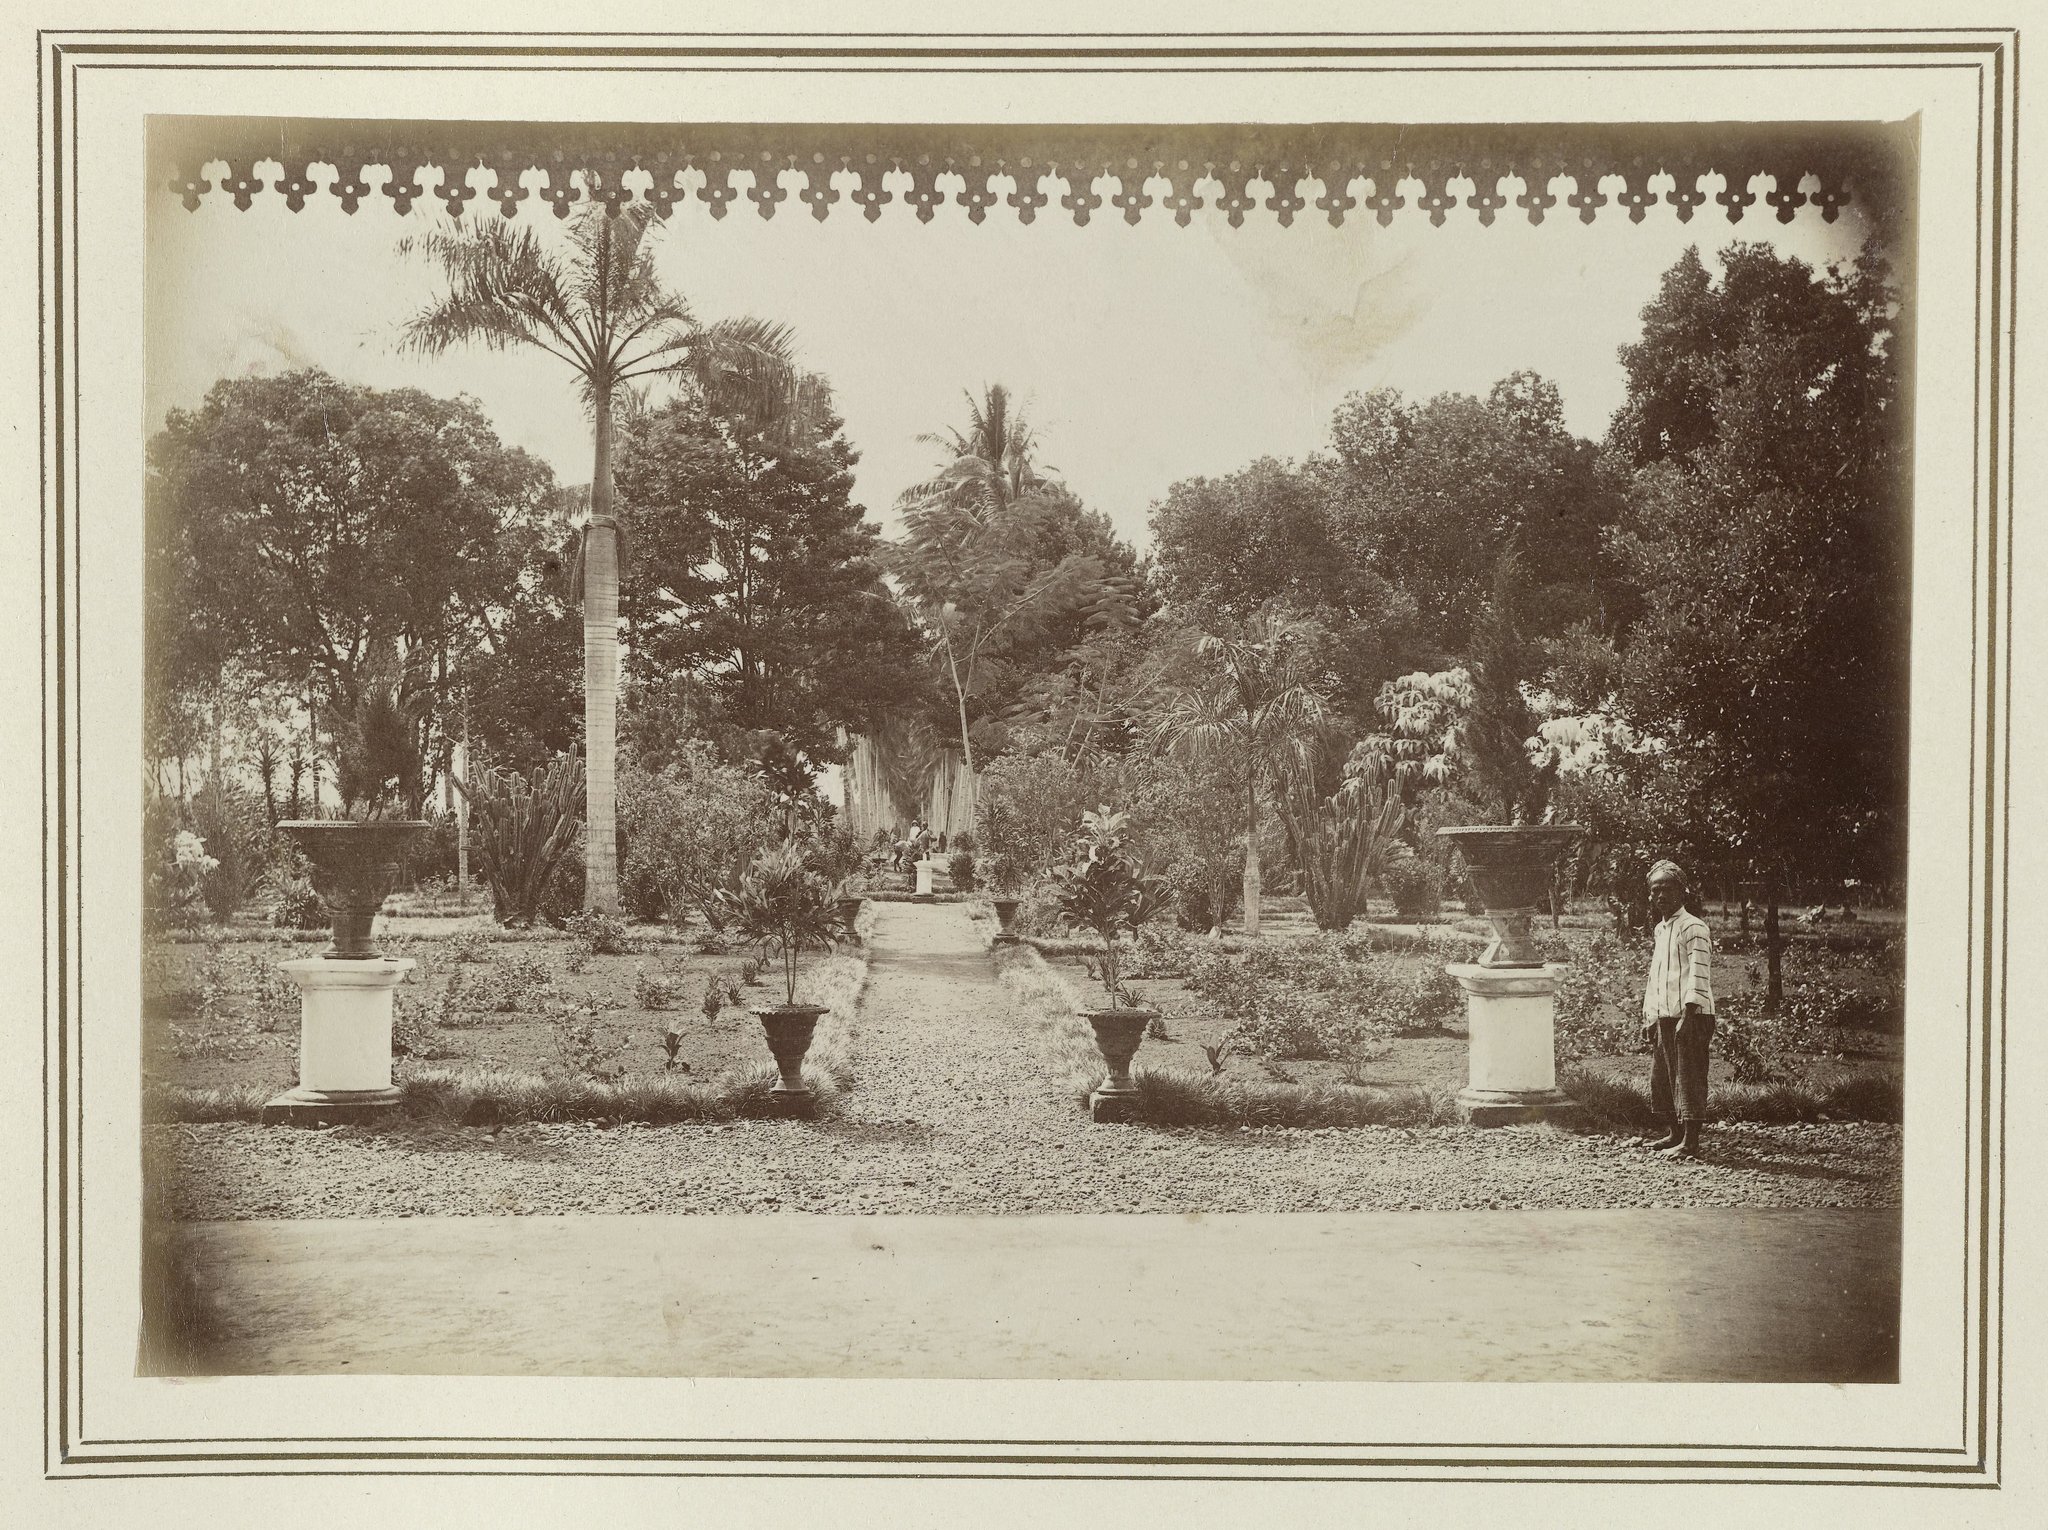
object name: photograph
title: Siertuin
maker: kassian céphas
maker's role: fotograaf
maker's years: 1845-1912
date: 1886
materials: photographic support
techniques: albumen print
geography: jogjakarta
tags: ornamental plants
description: Gezicht vanuit een woonhuis op een siertuin met planten en siervazen. Onderdeel van het fotoalbum aangeboden aan J.M. Pijnacker Hordijk bij zijn vertrek uit Jogyakarta in 1886.